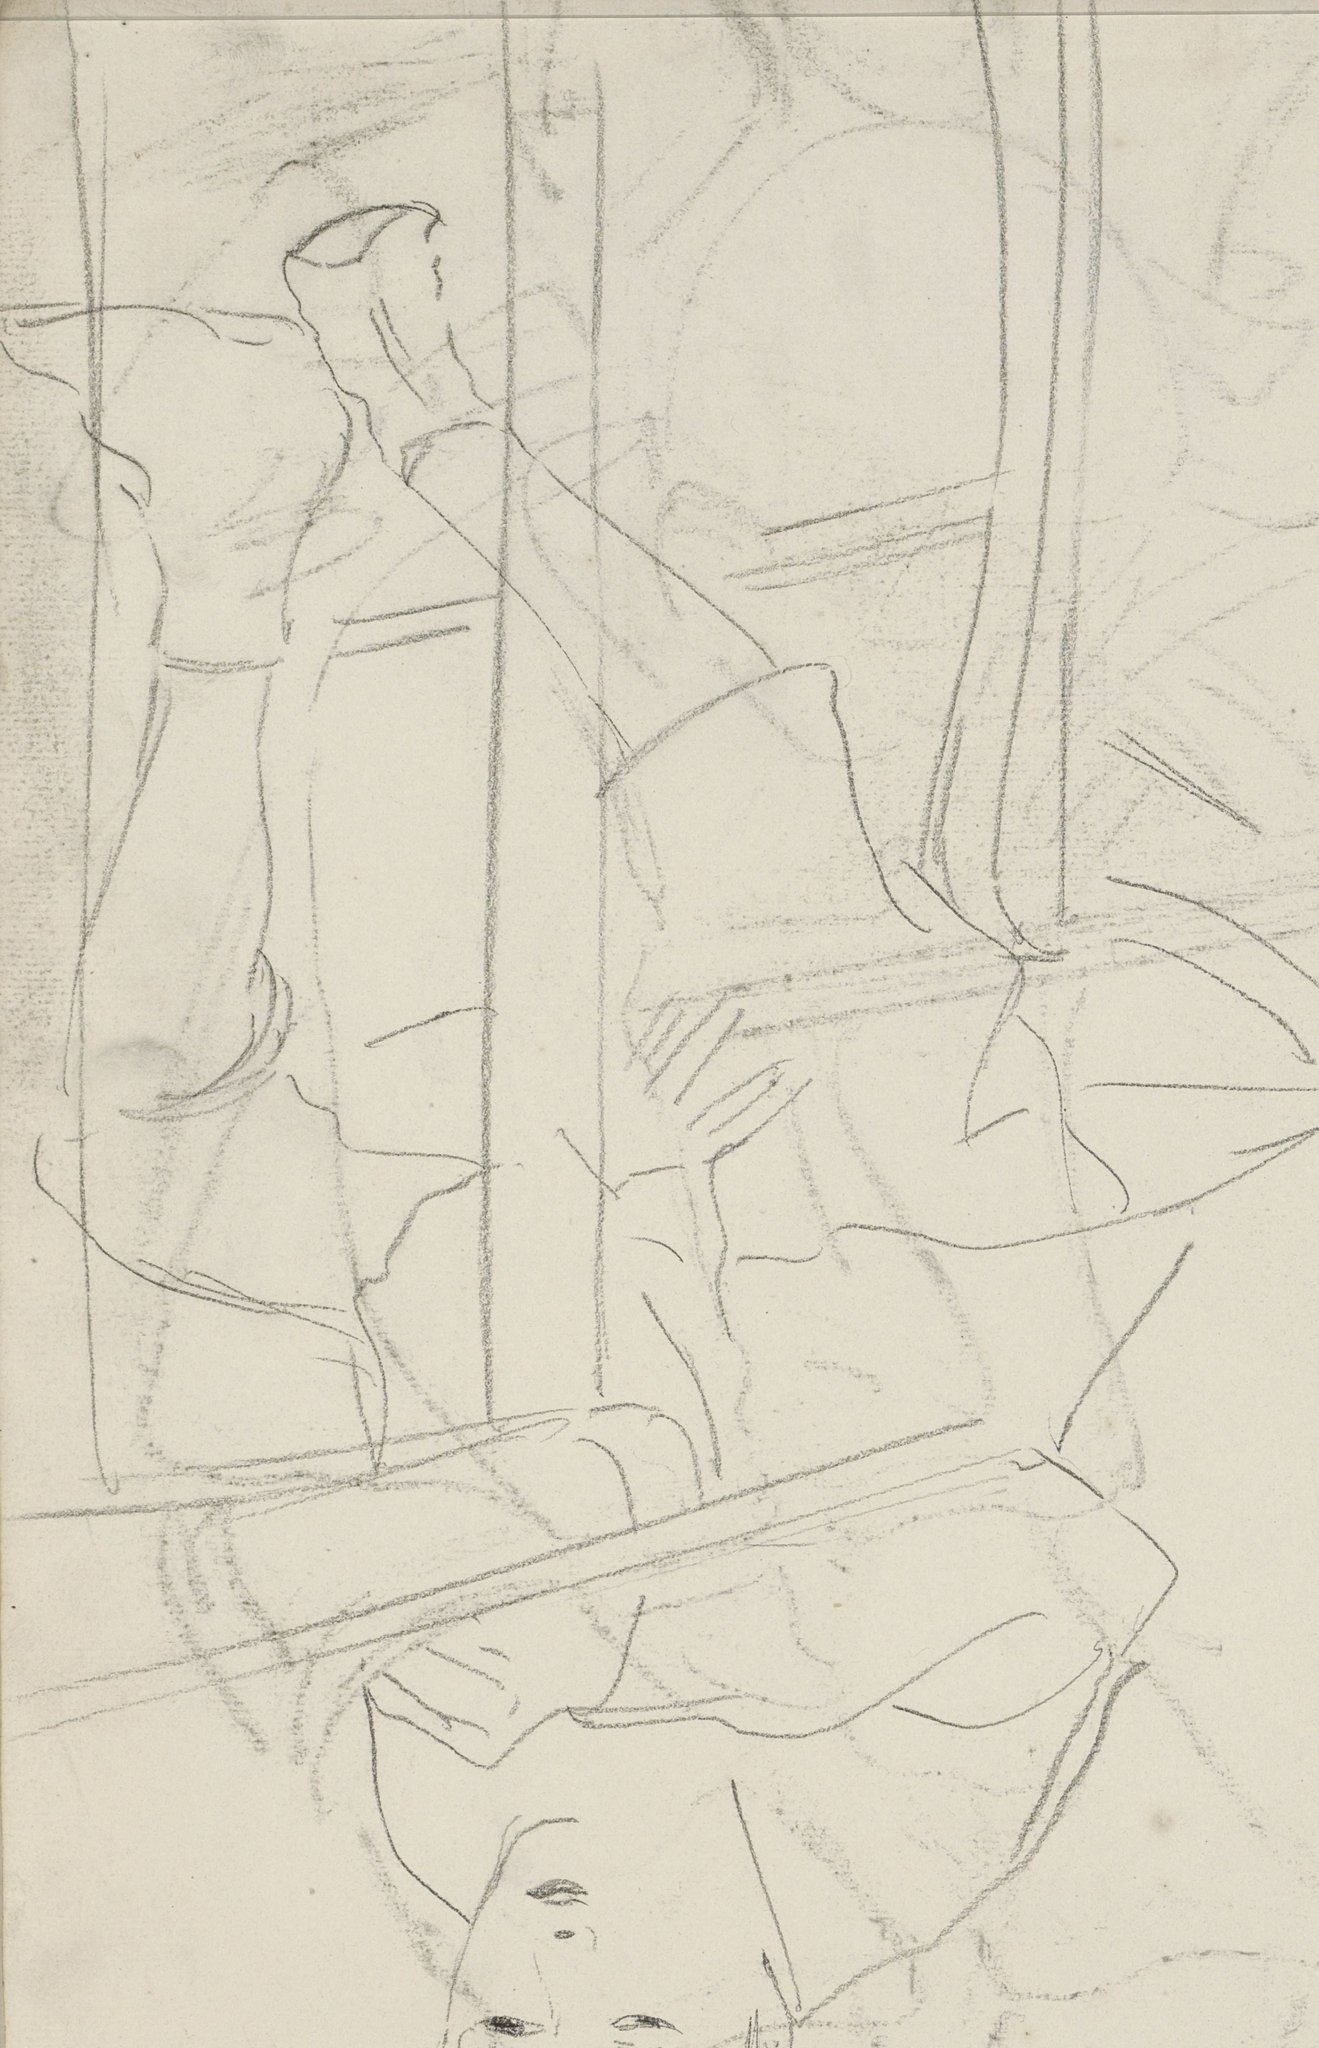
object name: sketchbook leaf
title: Jongen zittend aan een tekentafel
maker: carel adolph lion cachet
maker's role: draughtsman, print maker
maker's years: 1864-1945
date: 1895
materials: chalk, paper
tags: drawing, boy (child between toddler and youth)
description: Blad 5 verso uit een schetsboek met 23 bladen.